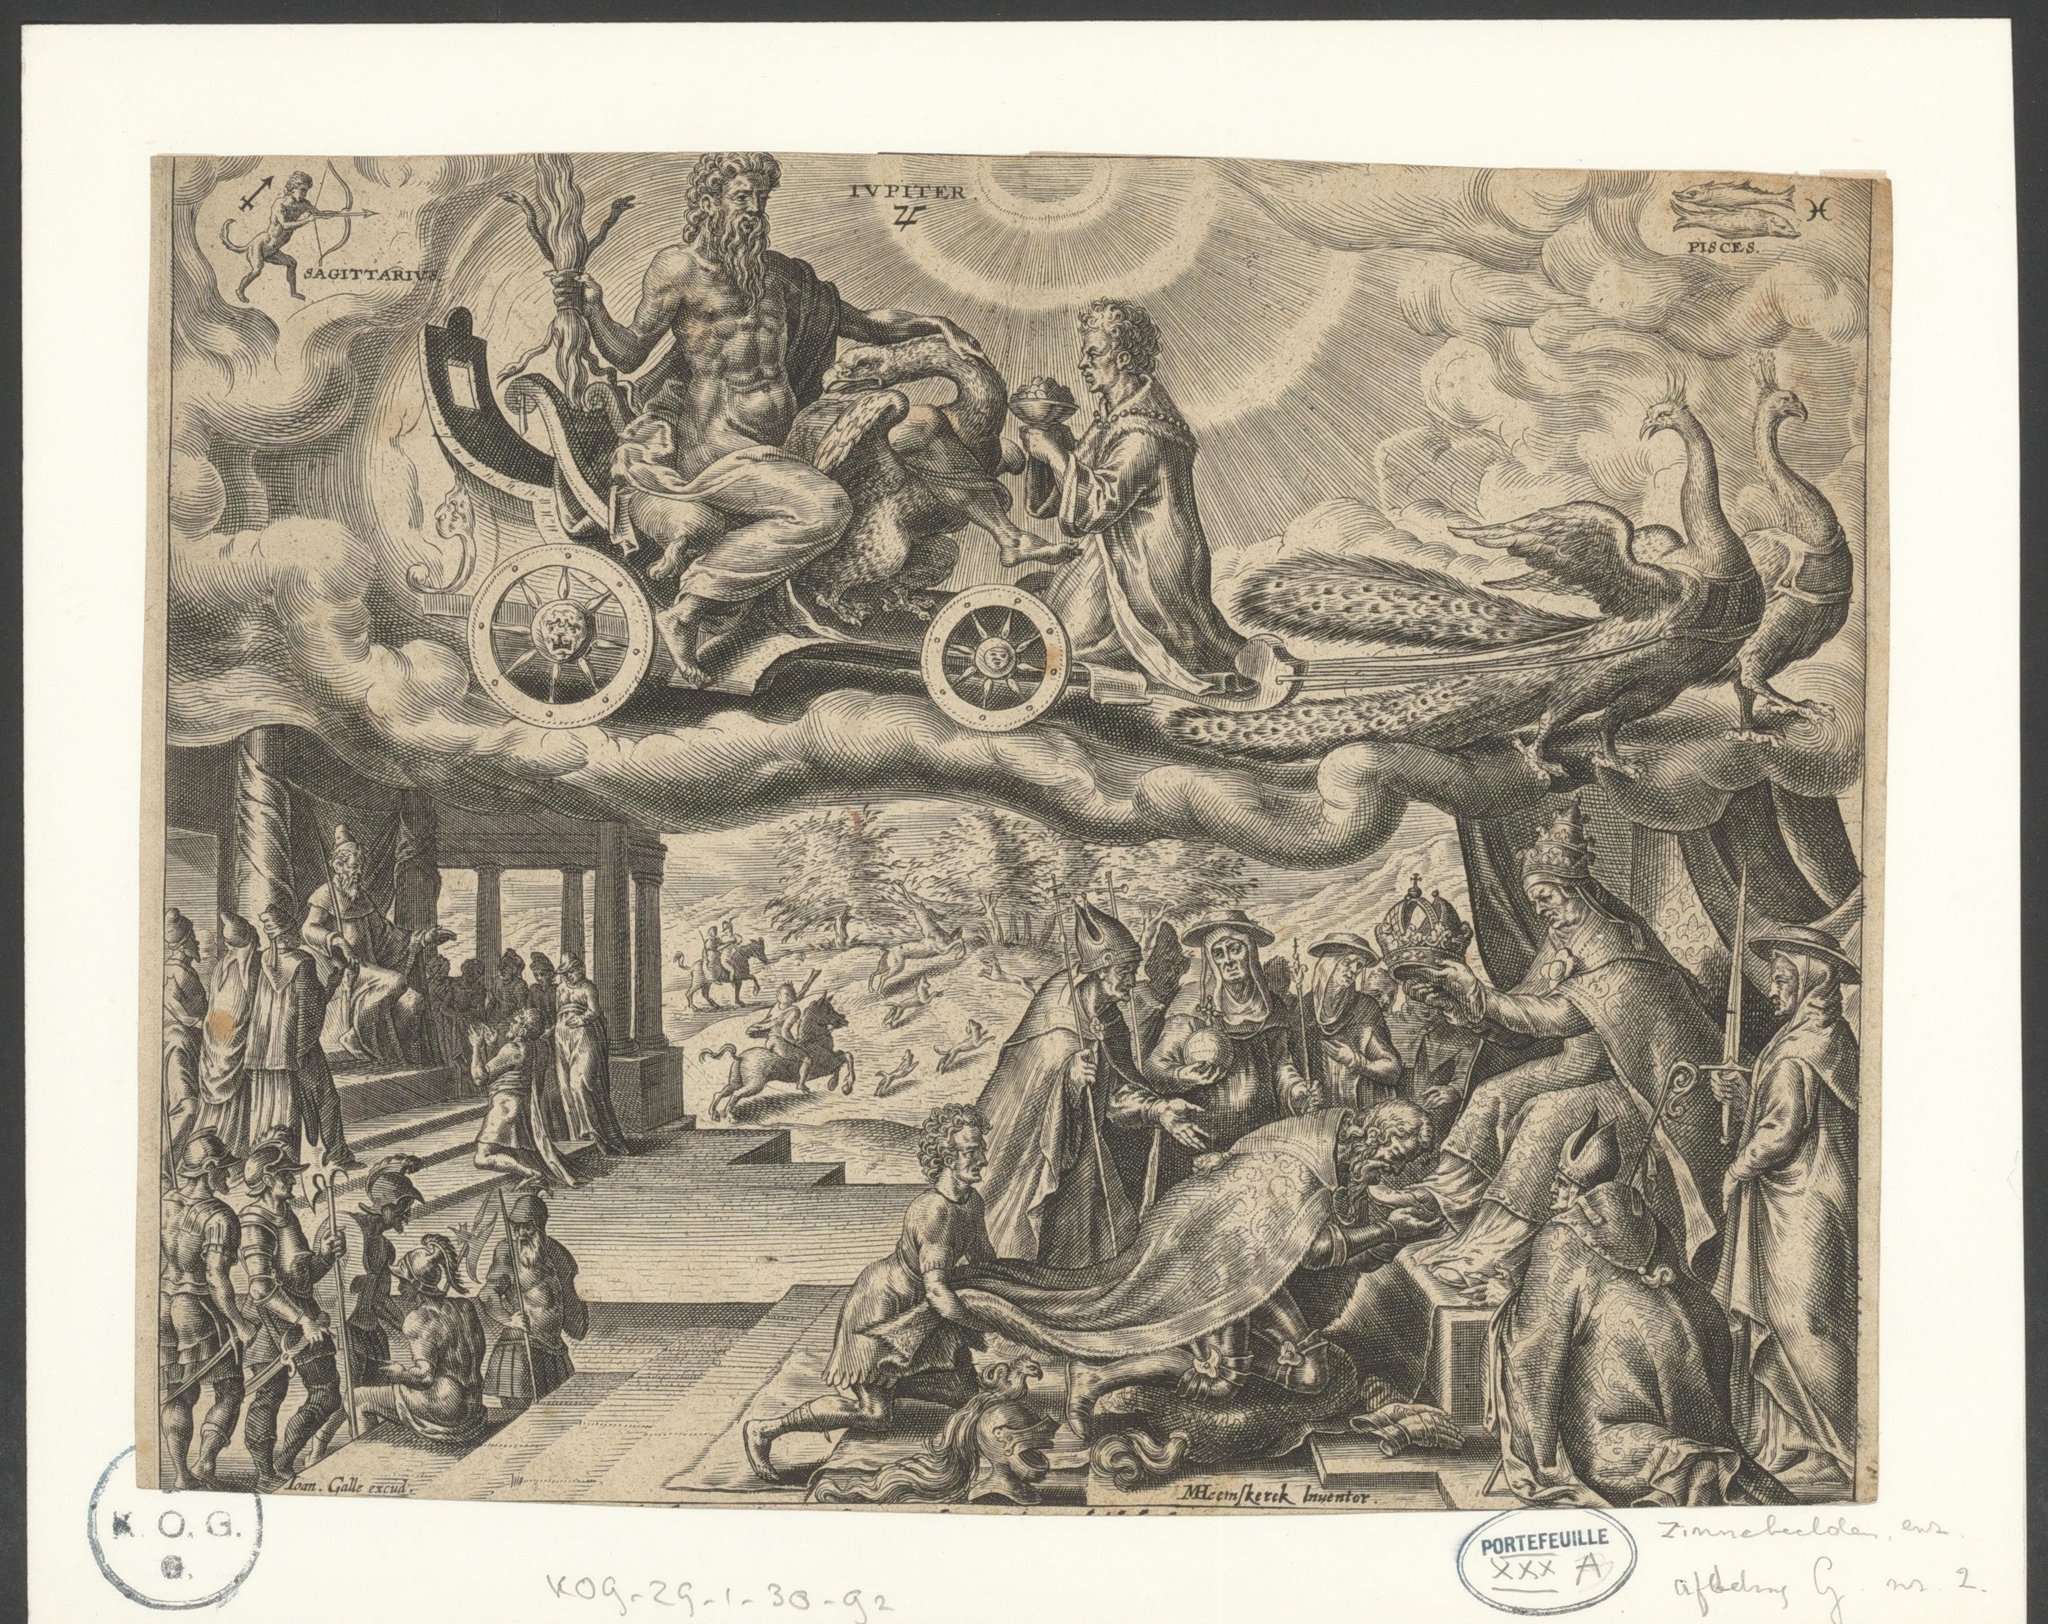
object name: print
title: De zeven planeten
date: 1638-1646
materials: paper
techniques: engraving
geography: antwerp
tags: hunting, chase, jupiter and his children ('planetenkinder') ~ pisces and sagittarius, ornamental birds: peacock, magistracy, judges, pope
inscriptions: collector's mark: Lugt 1641, stamp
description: Jupiter rijdt in zijn wagen aan de hemel, getrokken door twee pauwen. De tekens van Boogschutter en Vissen geven aan welke mensen tot de invloedssfeer van Jupiter behoren. De mensen, die onder dit sterrenbeeld geboren zijn, zijn wereldlijke of kerkelijke machthebbers. Een keizer wordt gekroond door de paus, die is omringd door kardinalen en bisschoppen. Links een rechter op zijn troon. Op de achtergrond wordt gejaagd. Onderaan in de marge een tekst in het Latijn over de kinderen van Jupiter. Onderwerpsrubrieken binnen de Atlas Zeden en Gewoonten: Zeden en Gewoonten in engeren zin. Volksleven. Zinnebeeldige voorstellingen uit het volkleven op serieprenten. Maanden en diversen (allegorieën).